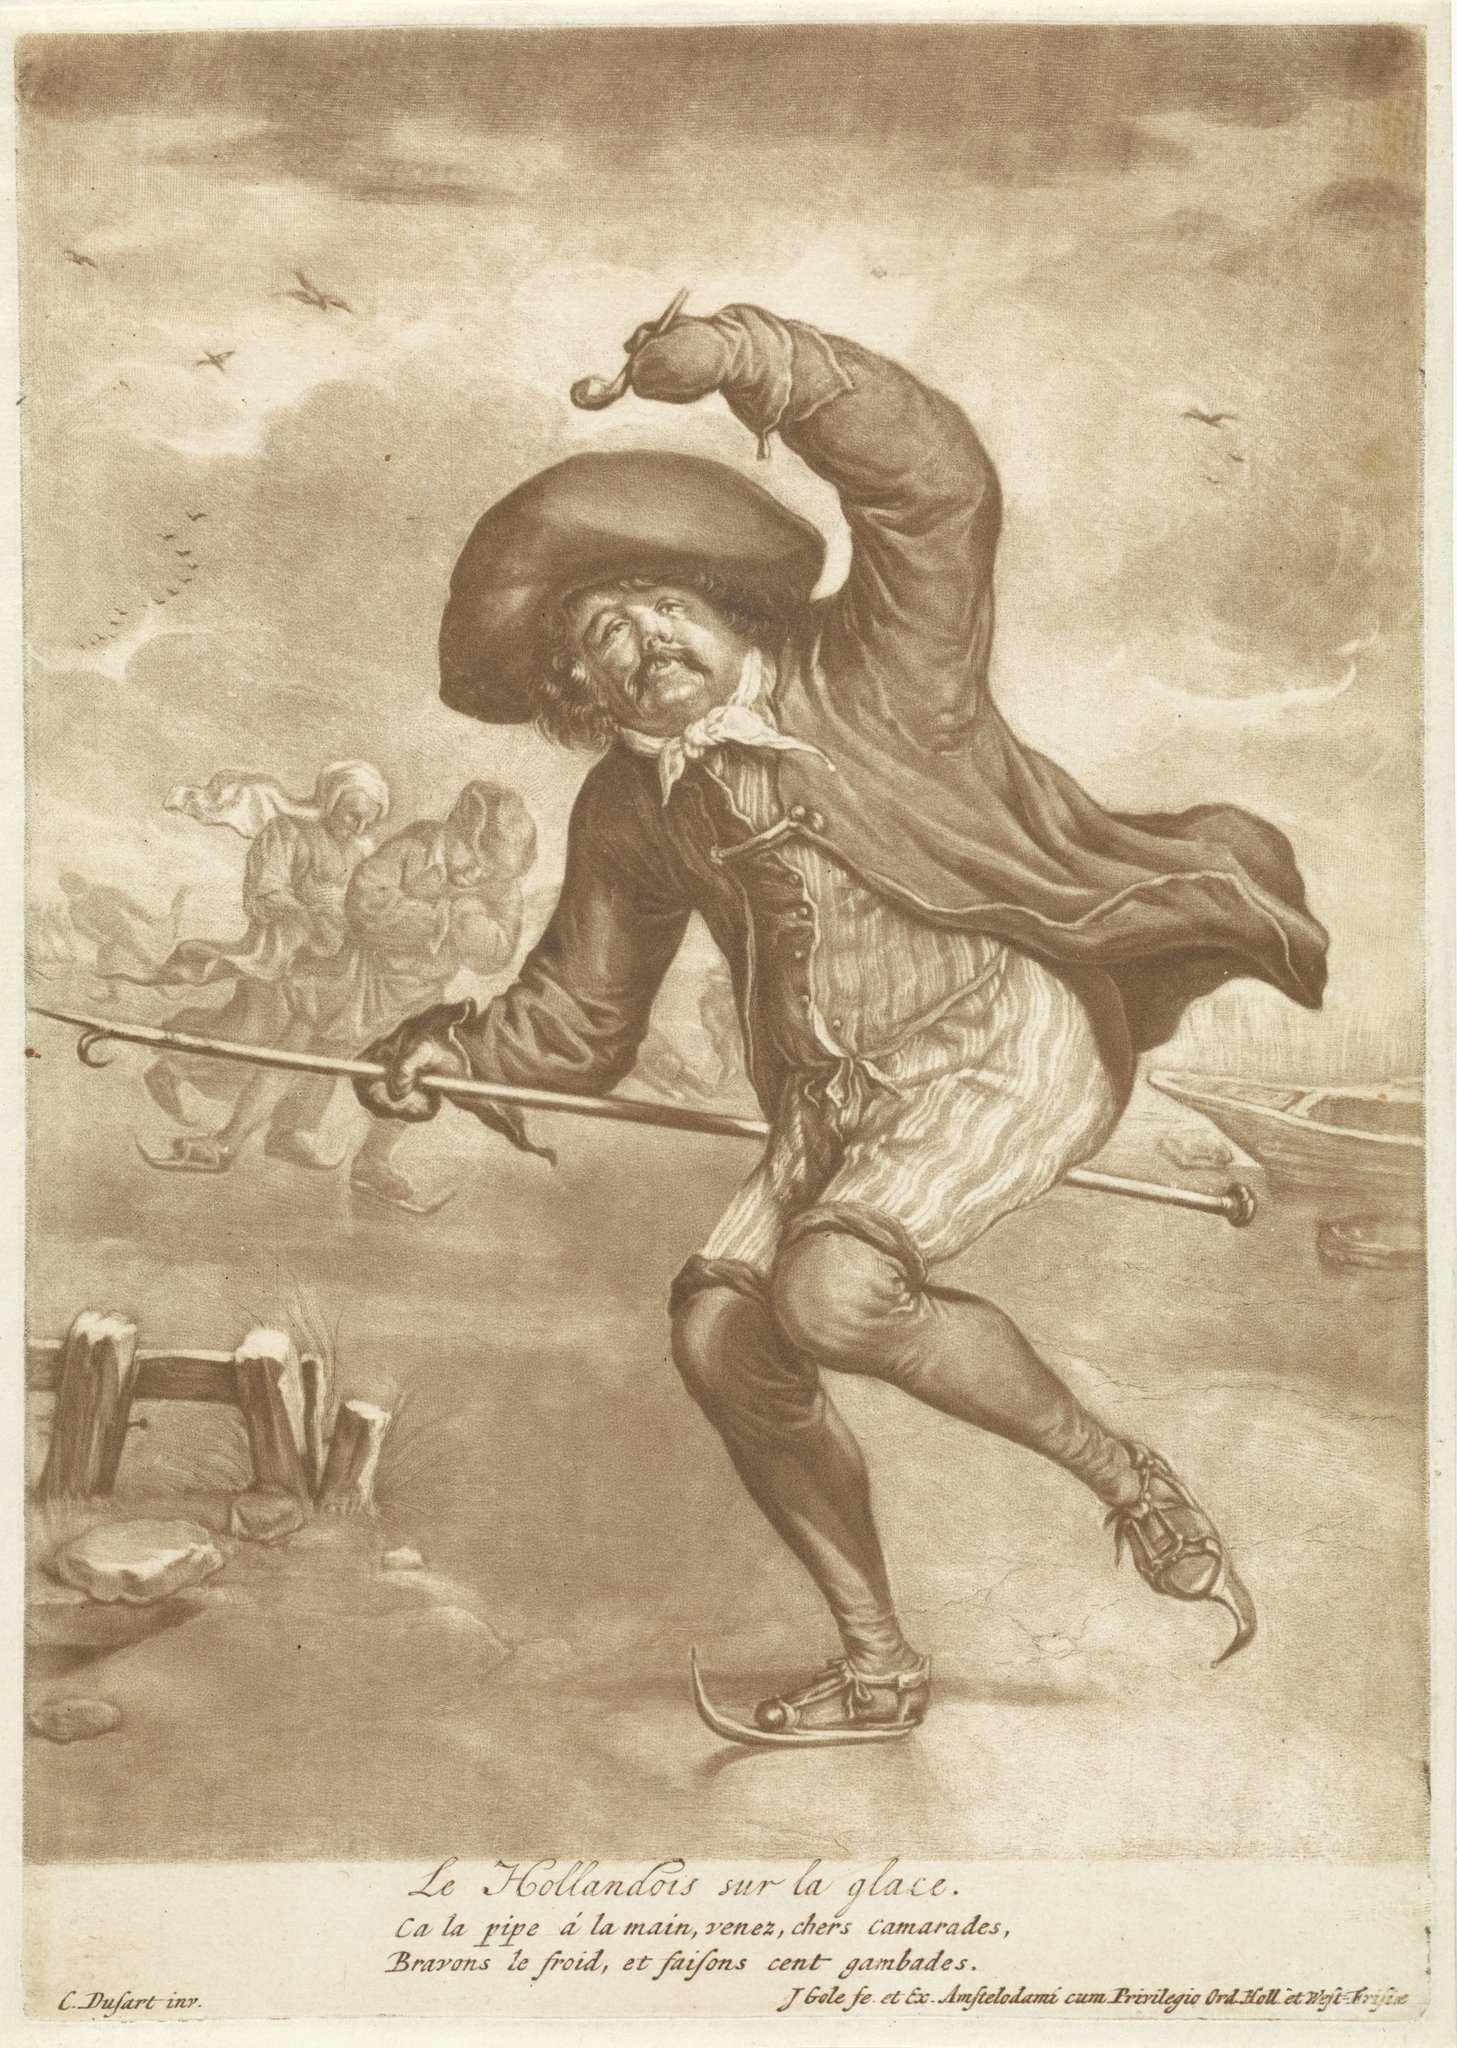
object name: print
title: Le Hollandois sur la glace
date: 1670-1724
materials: paper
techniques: printing, engraving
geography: amsterdam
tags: pipe ~ tobacco, skates (winter sports)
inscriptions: collector's mark: Lugt 240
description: Een schaatsende man op het ijs met in de hand een pijpje en een stok. Achter hem enkele schaatsers.